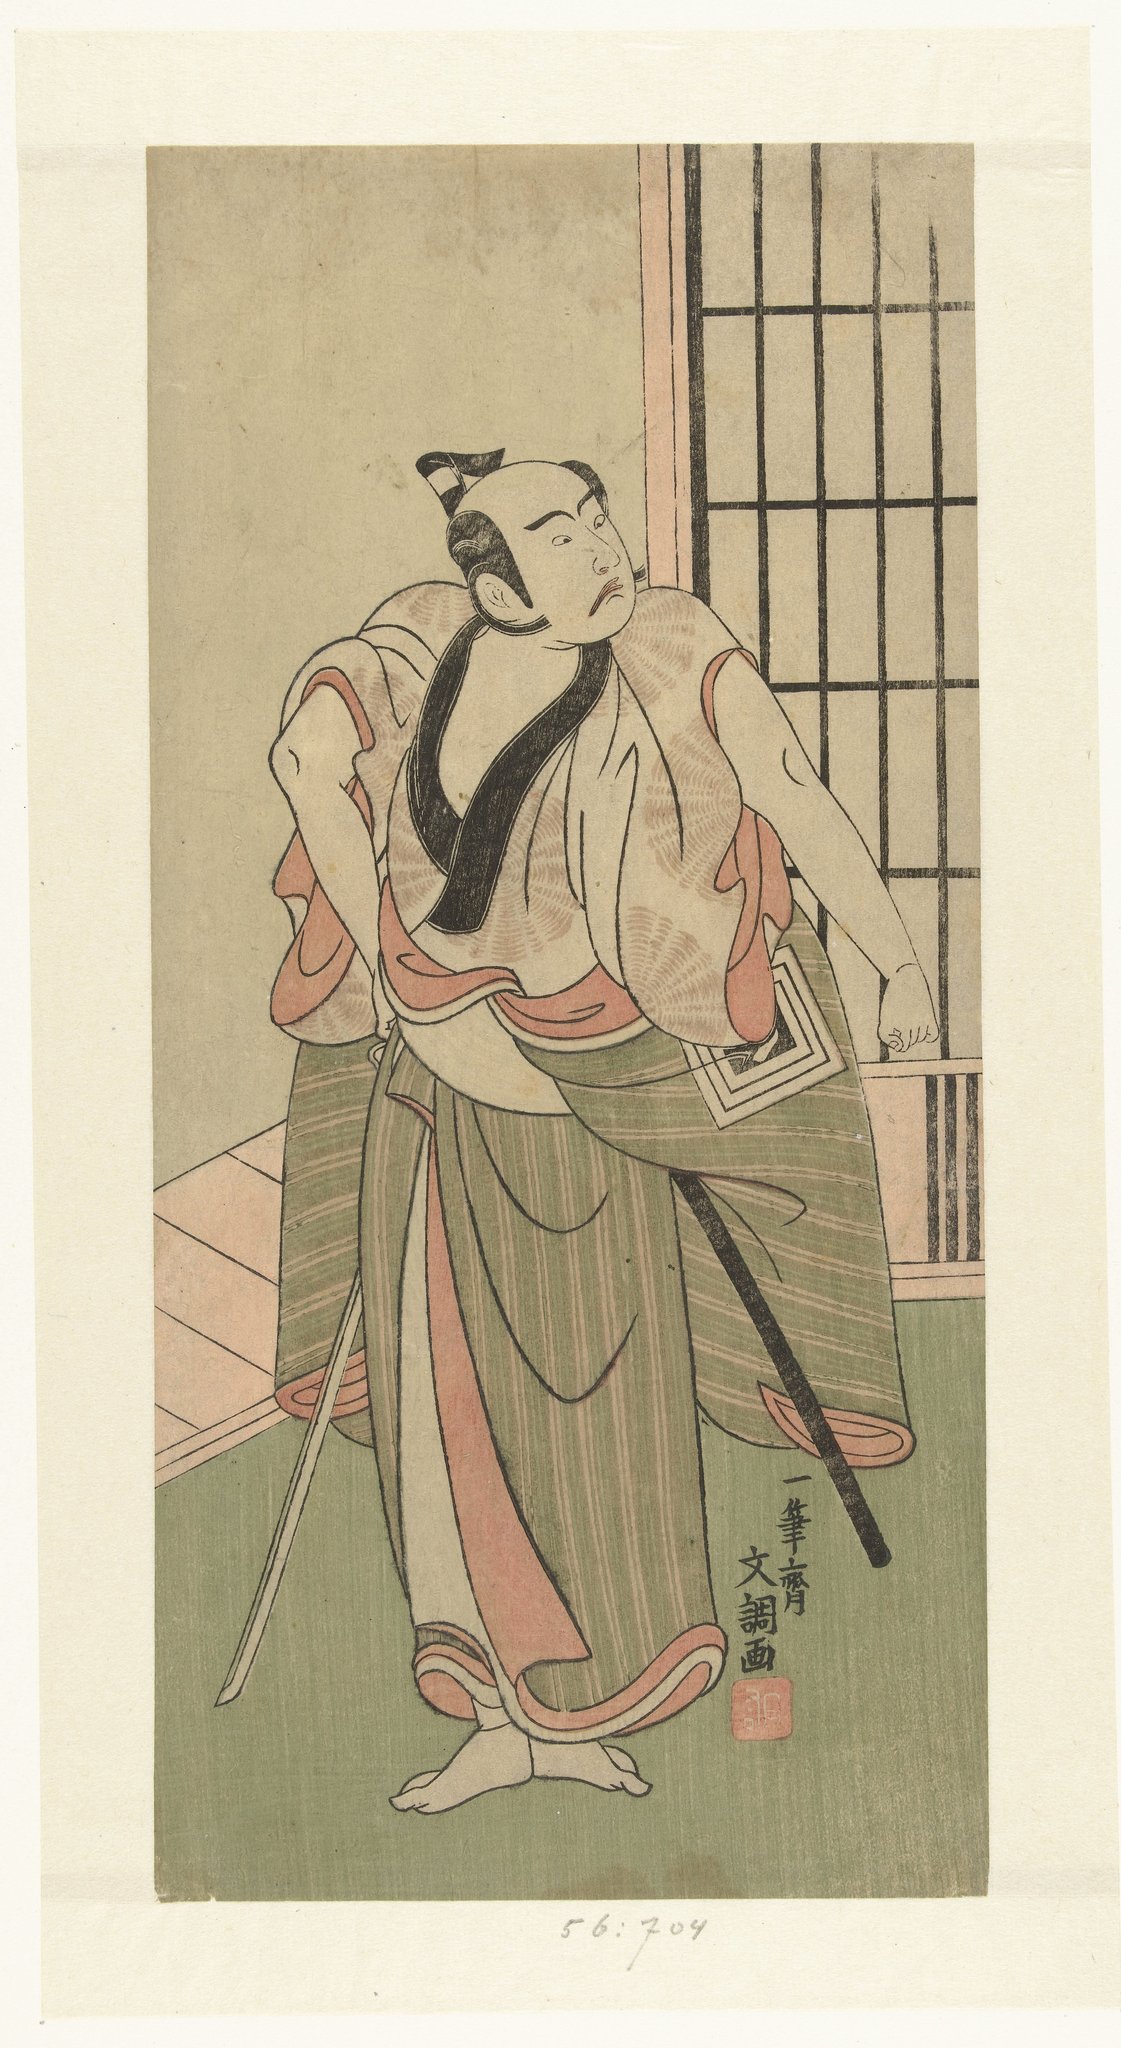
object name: print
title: Acteur Ichikawa Yaozo II met getrokken zwaard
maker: ippitsusai bunchô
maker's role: print maker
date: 1768-1772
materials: paper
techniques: woodcut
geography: japan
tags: group of actors, troupe; actors on the stage, hacking and thrusting weapons: sword